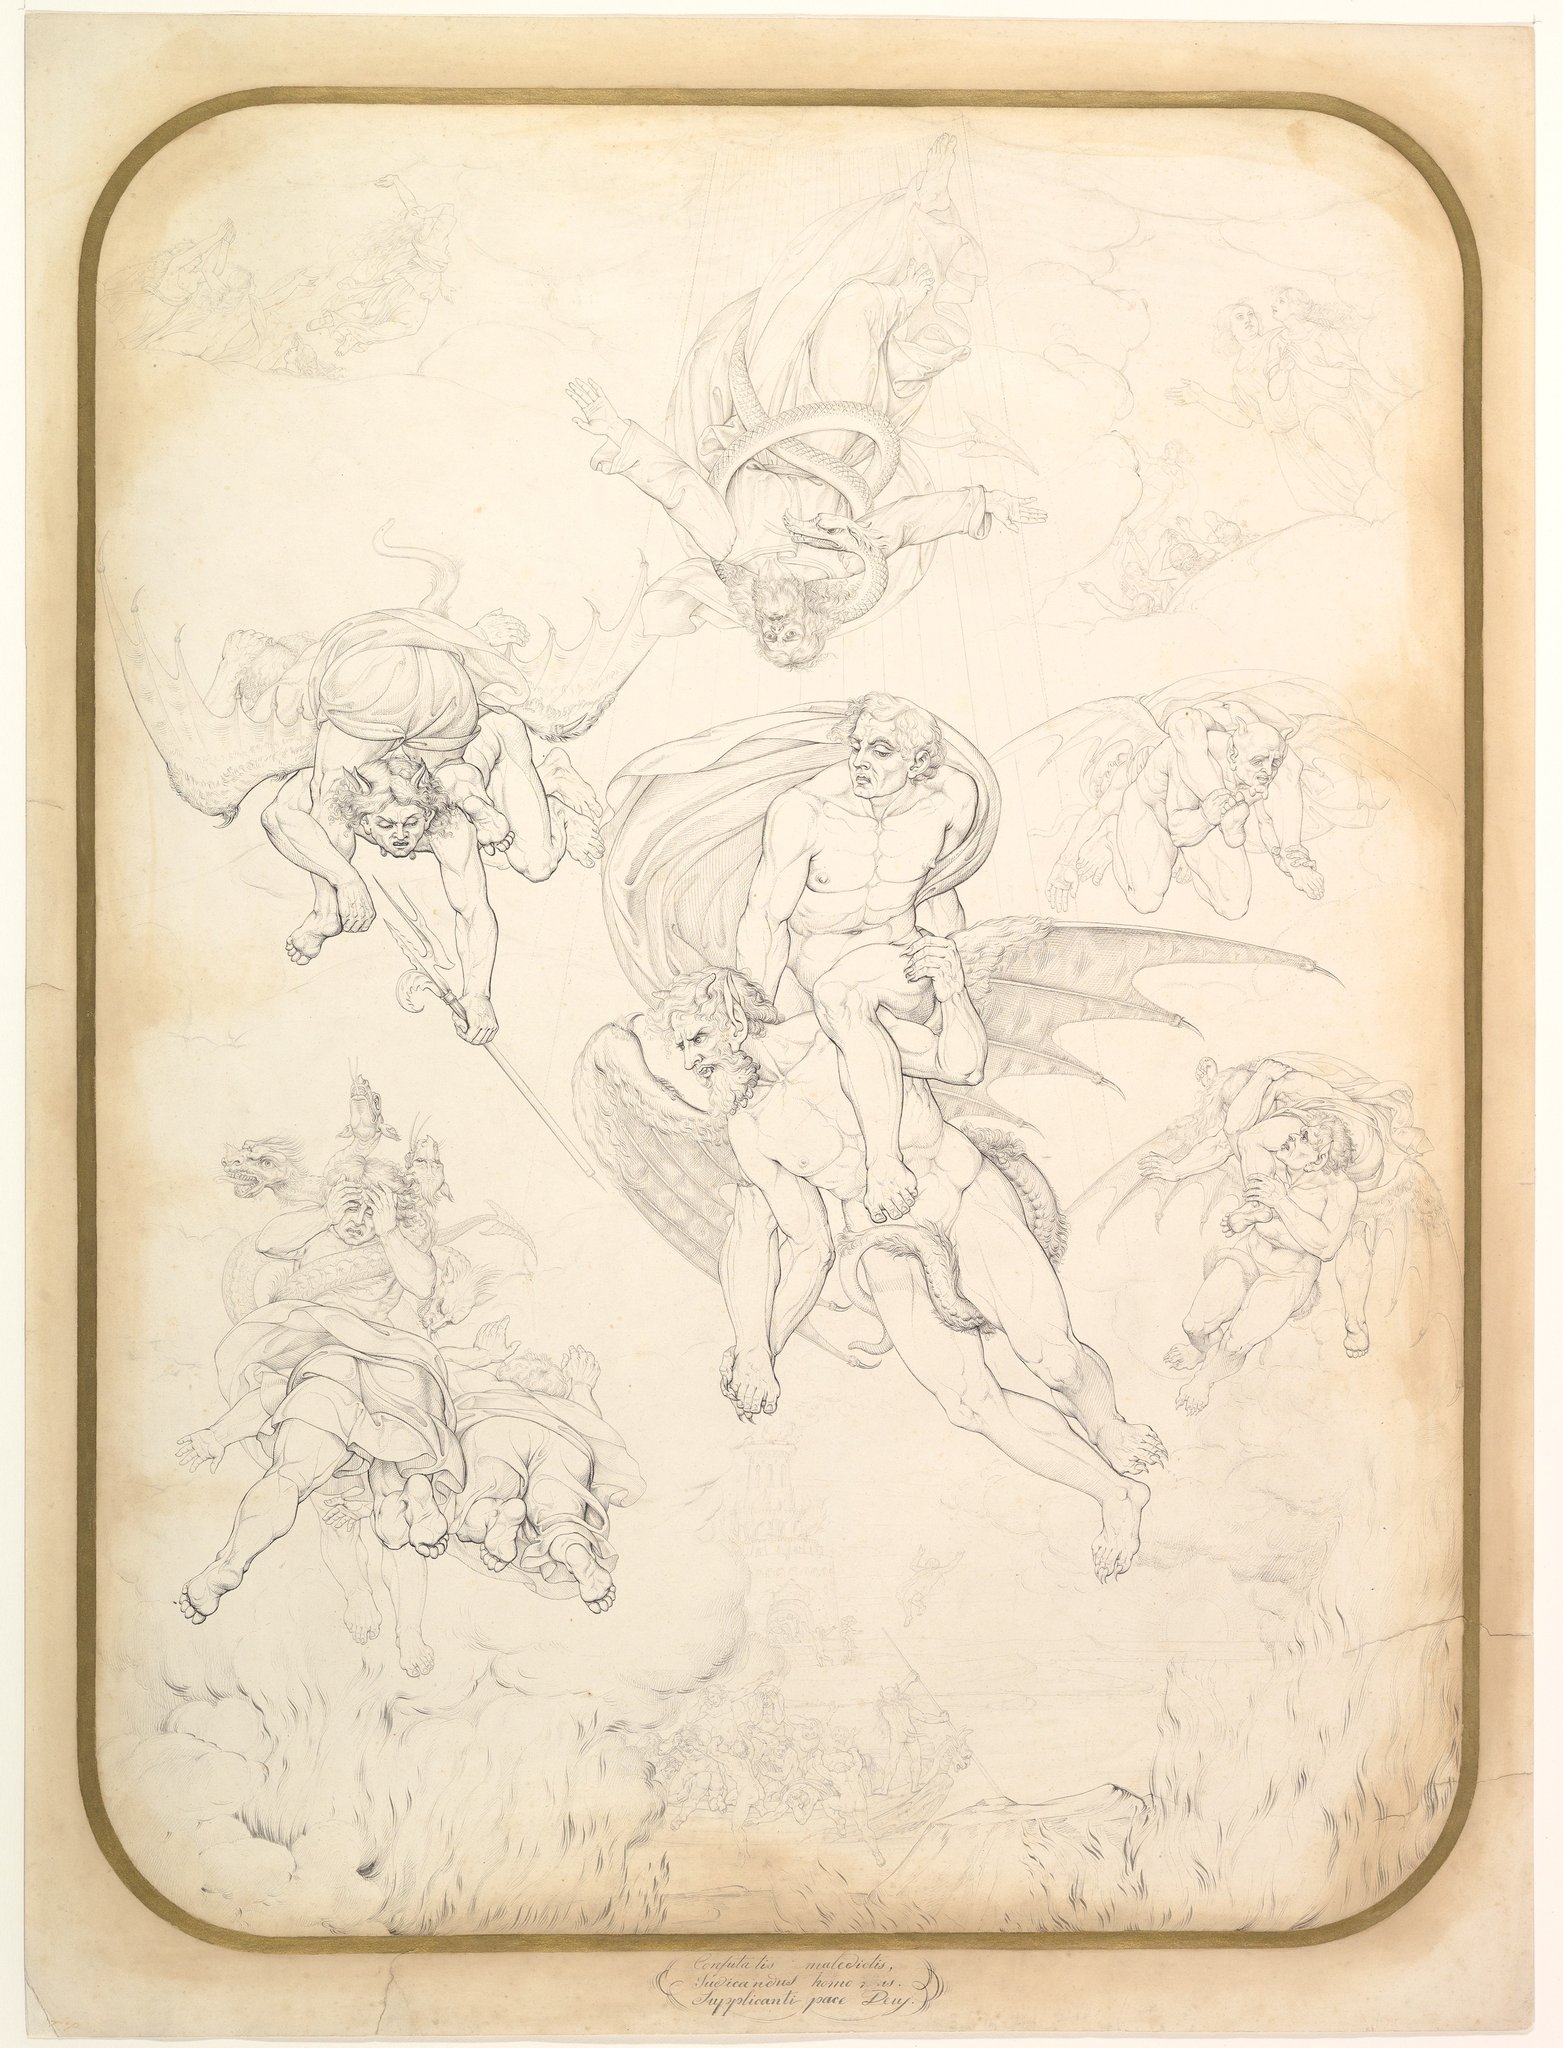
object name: drawing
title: Last Judgment, after Michelangelo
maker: tommaso piroli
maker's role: artist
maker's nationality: italian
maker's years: 1752-1824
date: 1752-1824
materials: graphite, ink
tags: last judgement